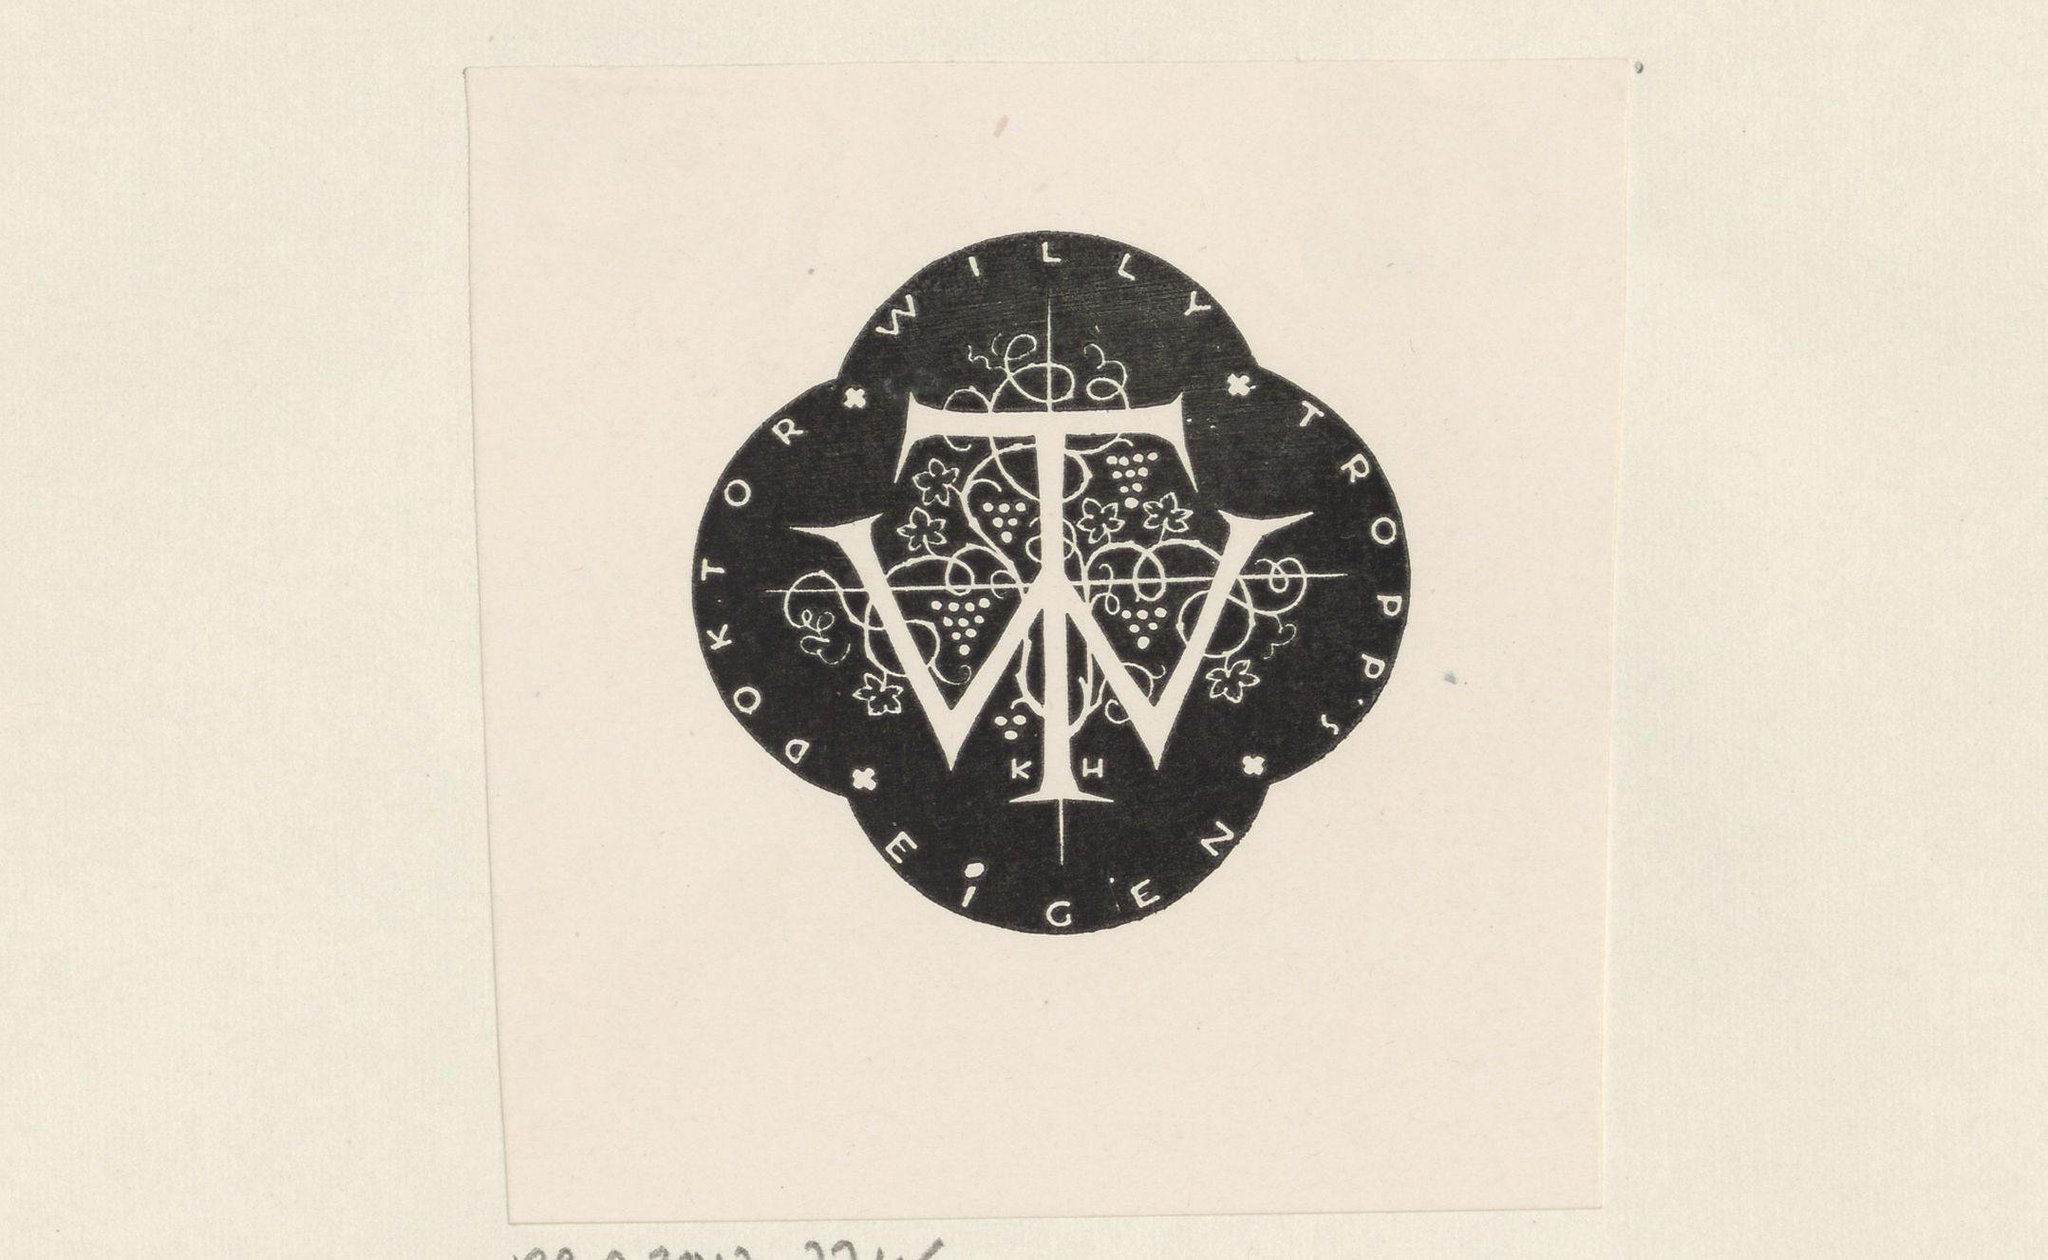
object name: bookplate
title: Doktor Willy Tropp's eigen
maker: karl haselböck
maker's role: print maker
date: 1934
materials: paper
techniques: engraving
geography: austria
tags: vine